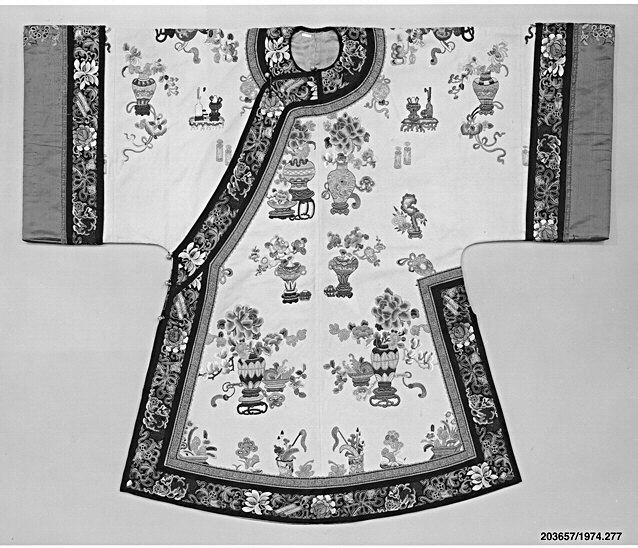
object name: woman's informal robe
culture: chinese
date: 1801-1900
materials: silk, wool